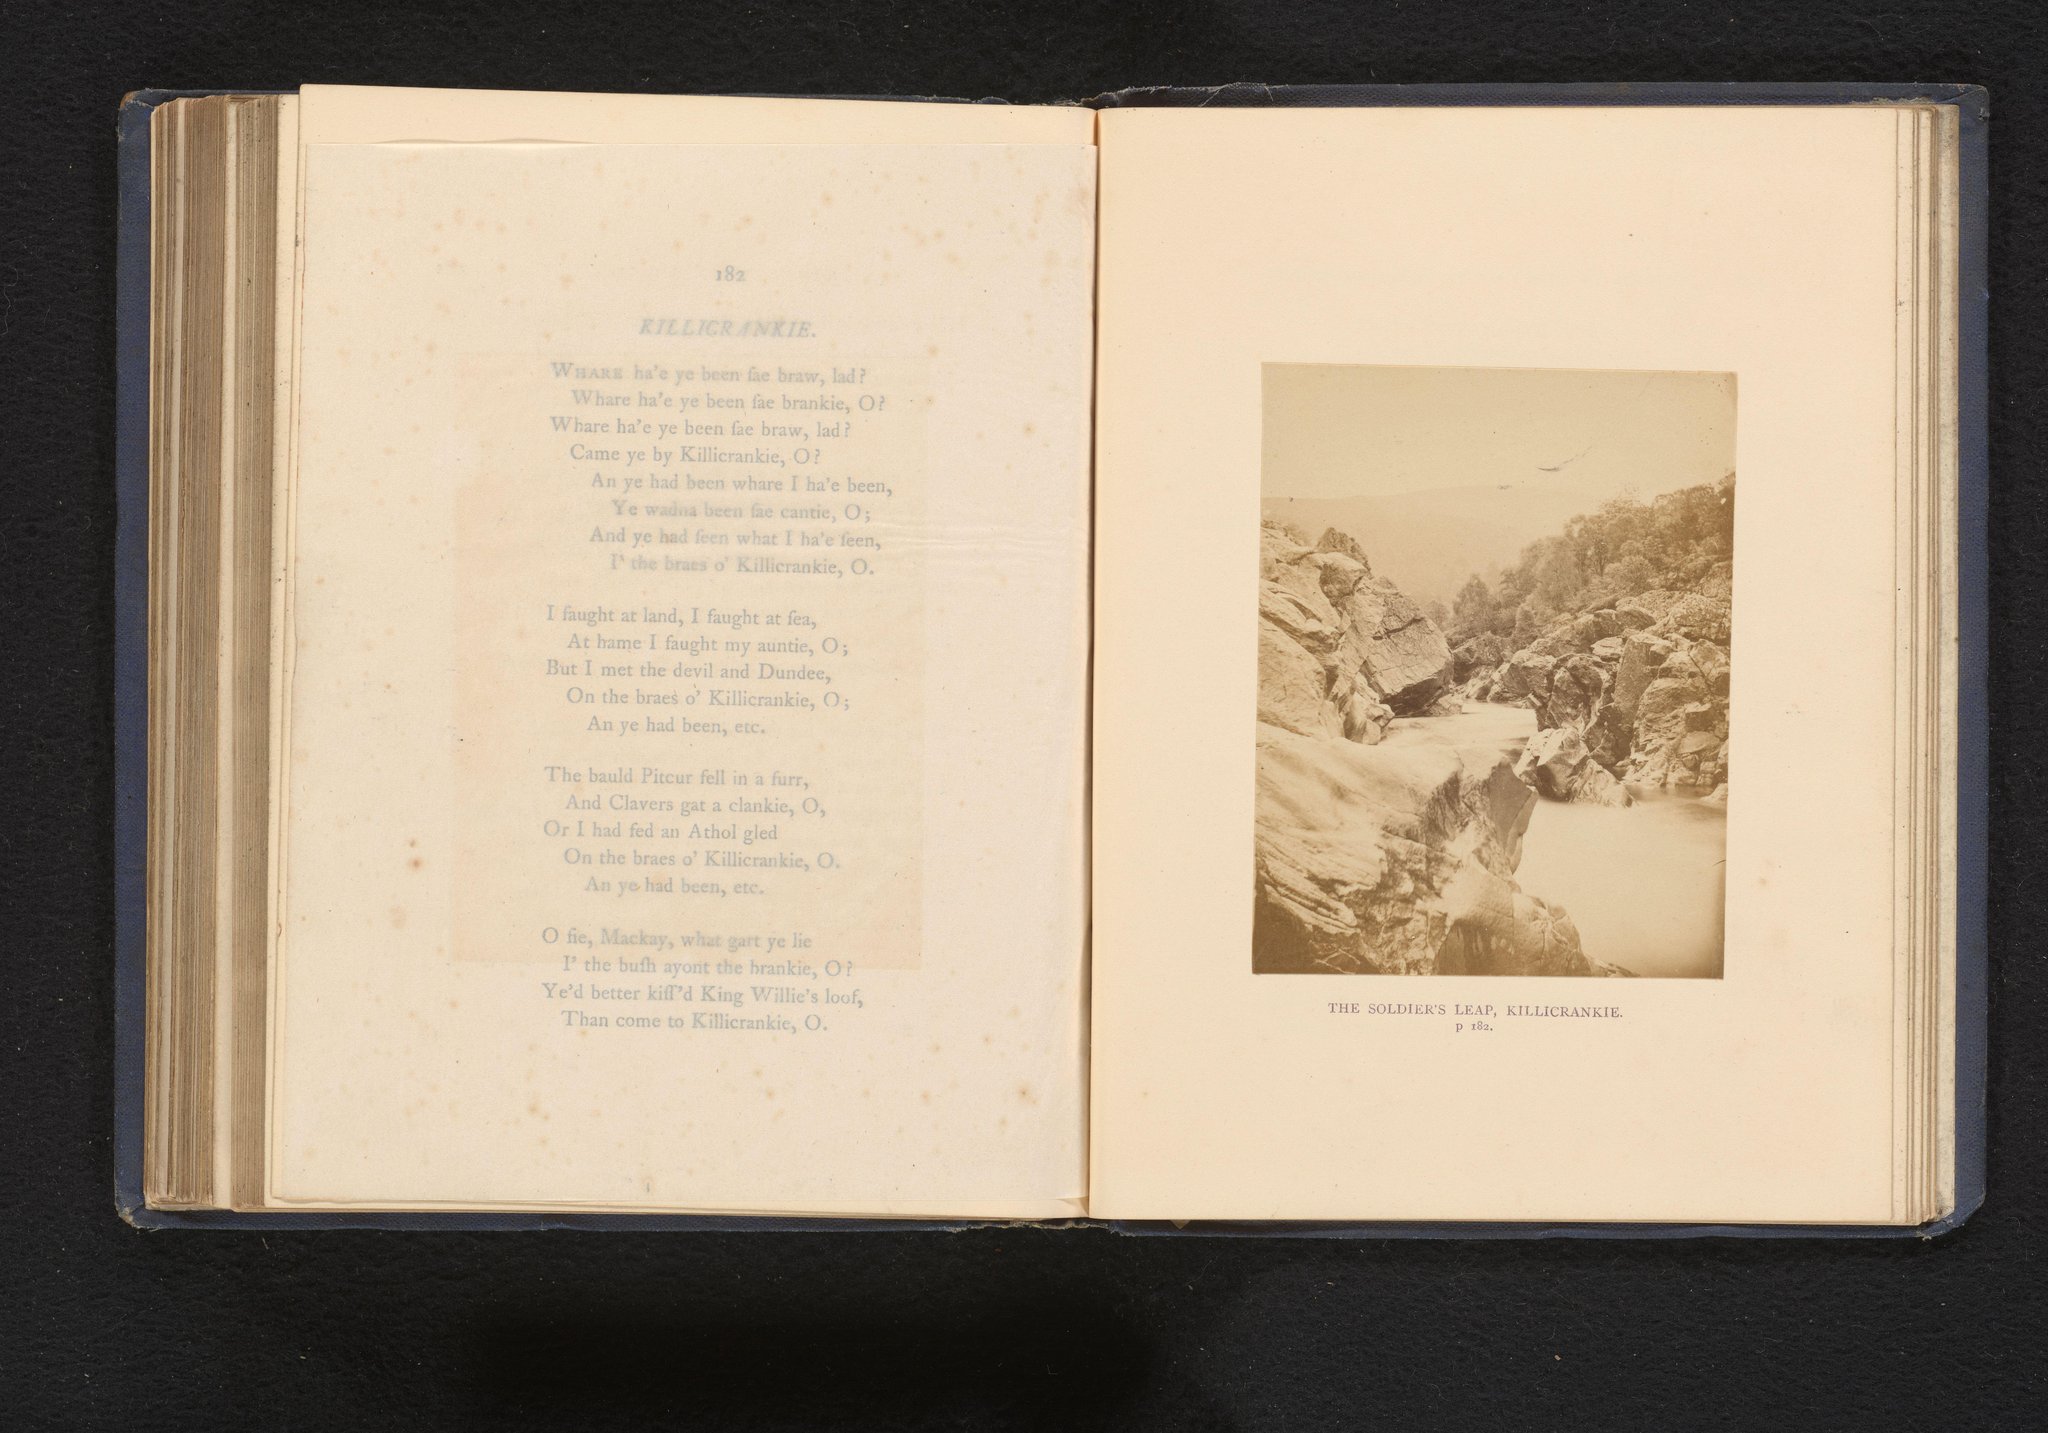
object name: photograph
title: Gezicht op de Soldier's Leap over de rivier Garry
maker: peter ewing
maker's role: fotograaf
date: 1863-1868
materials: paper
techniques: albumen print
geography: killiecrankie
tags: river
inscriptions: inscription: ‘p. 182.’